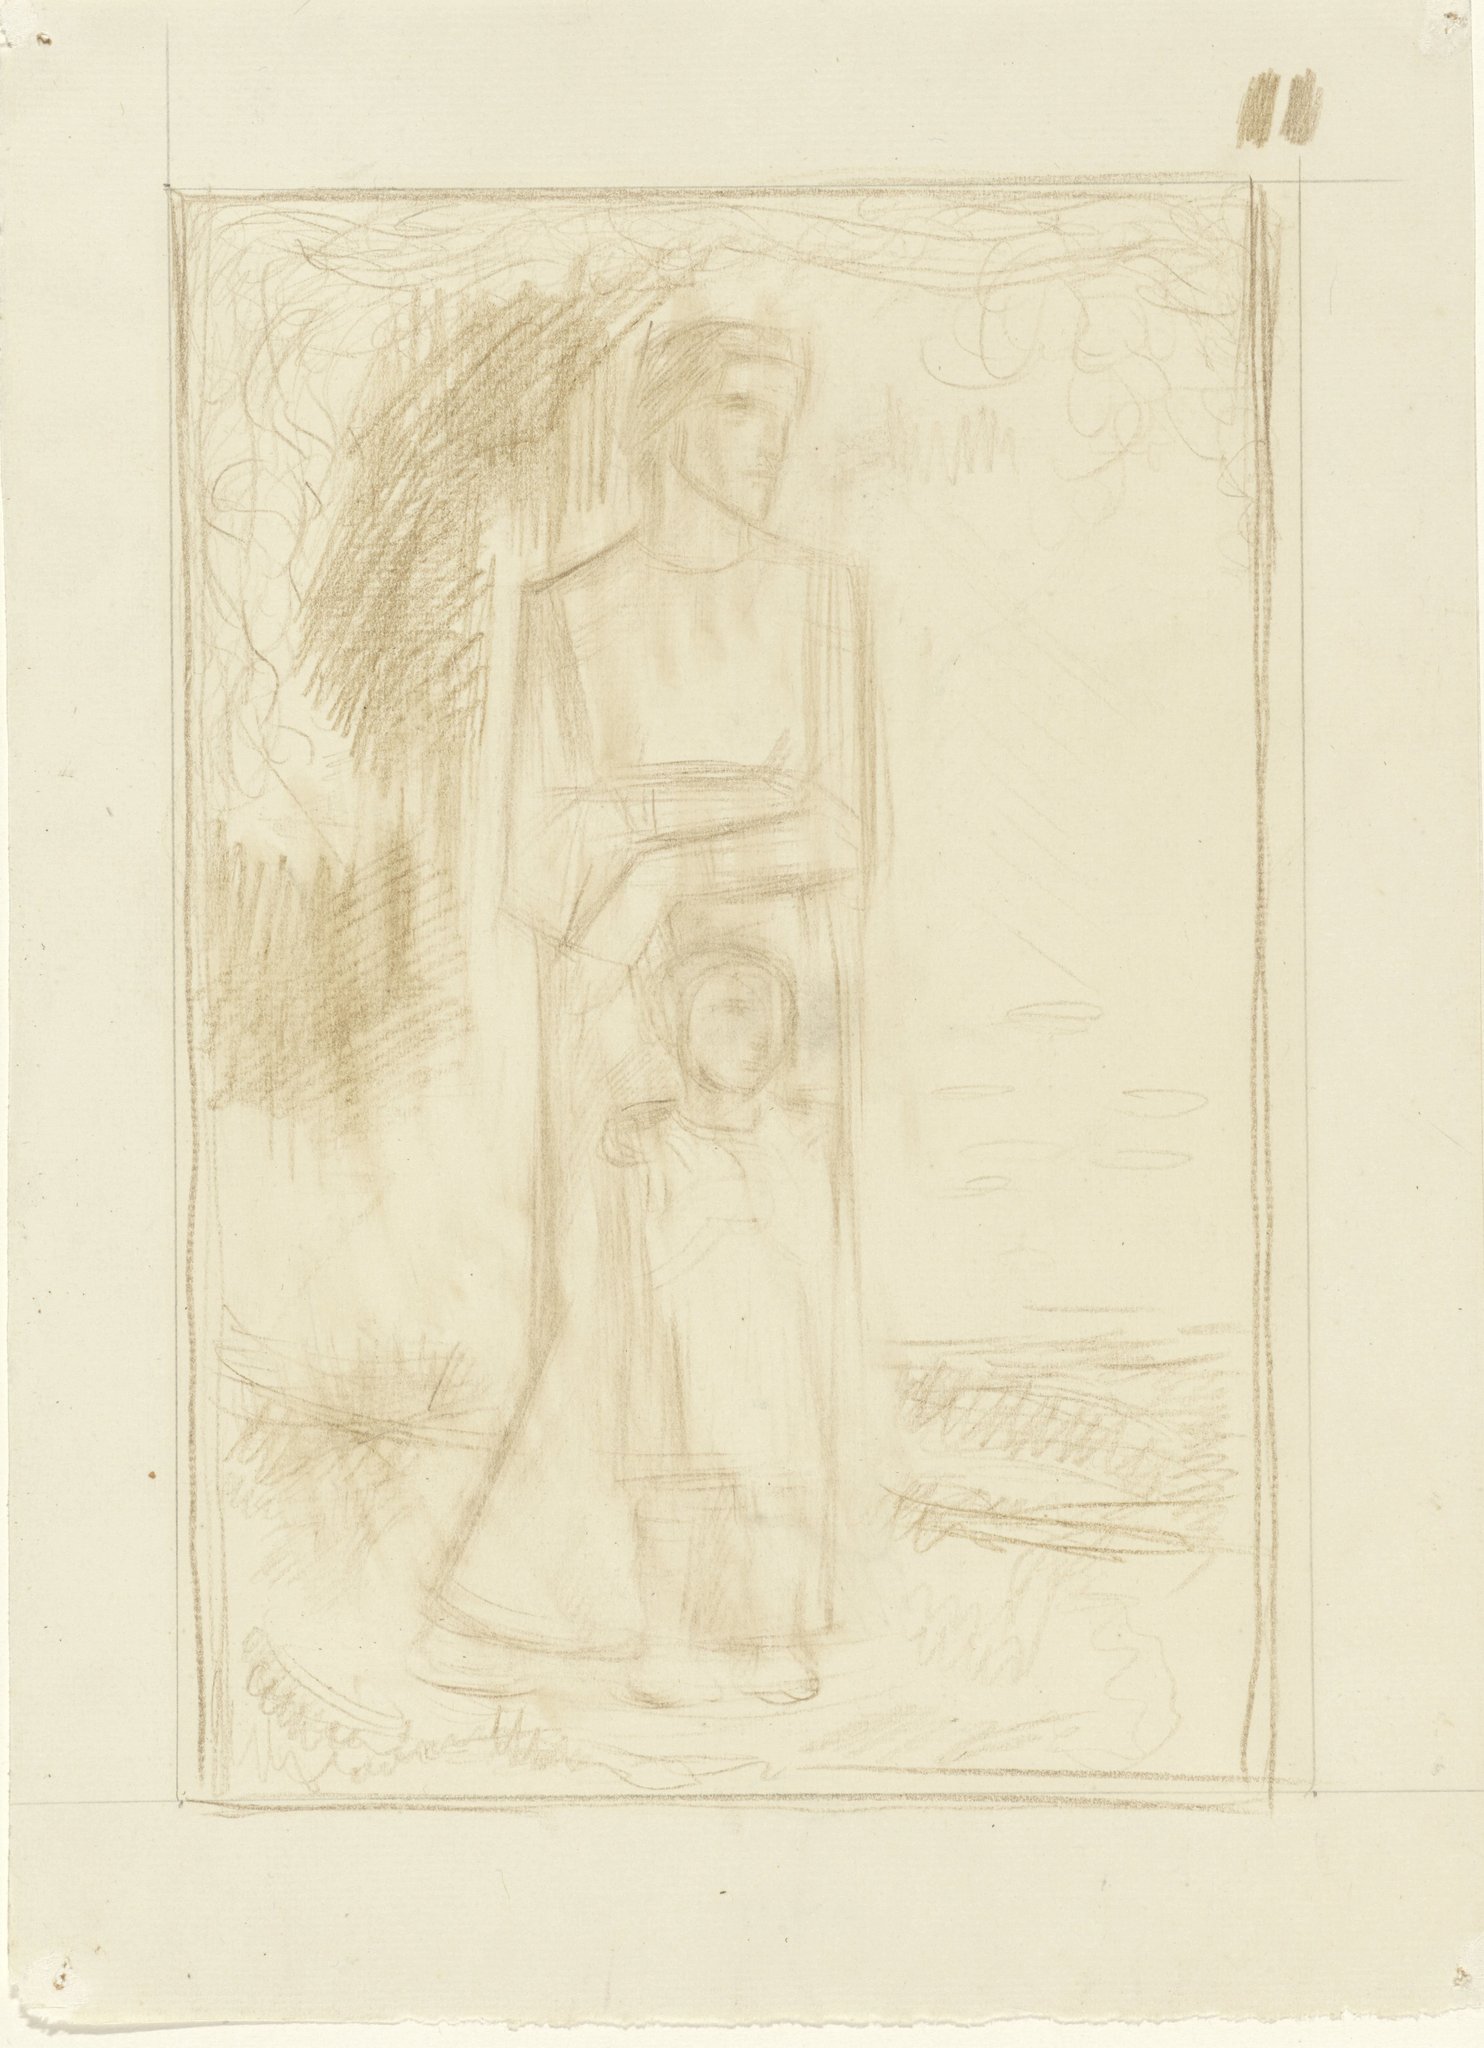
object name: drawing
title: Staande vrouw en kind in een landschap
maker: richard nicolaüs roland holst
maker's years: 1868-1938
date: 1878-1938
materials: chalk, paper